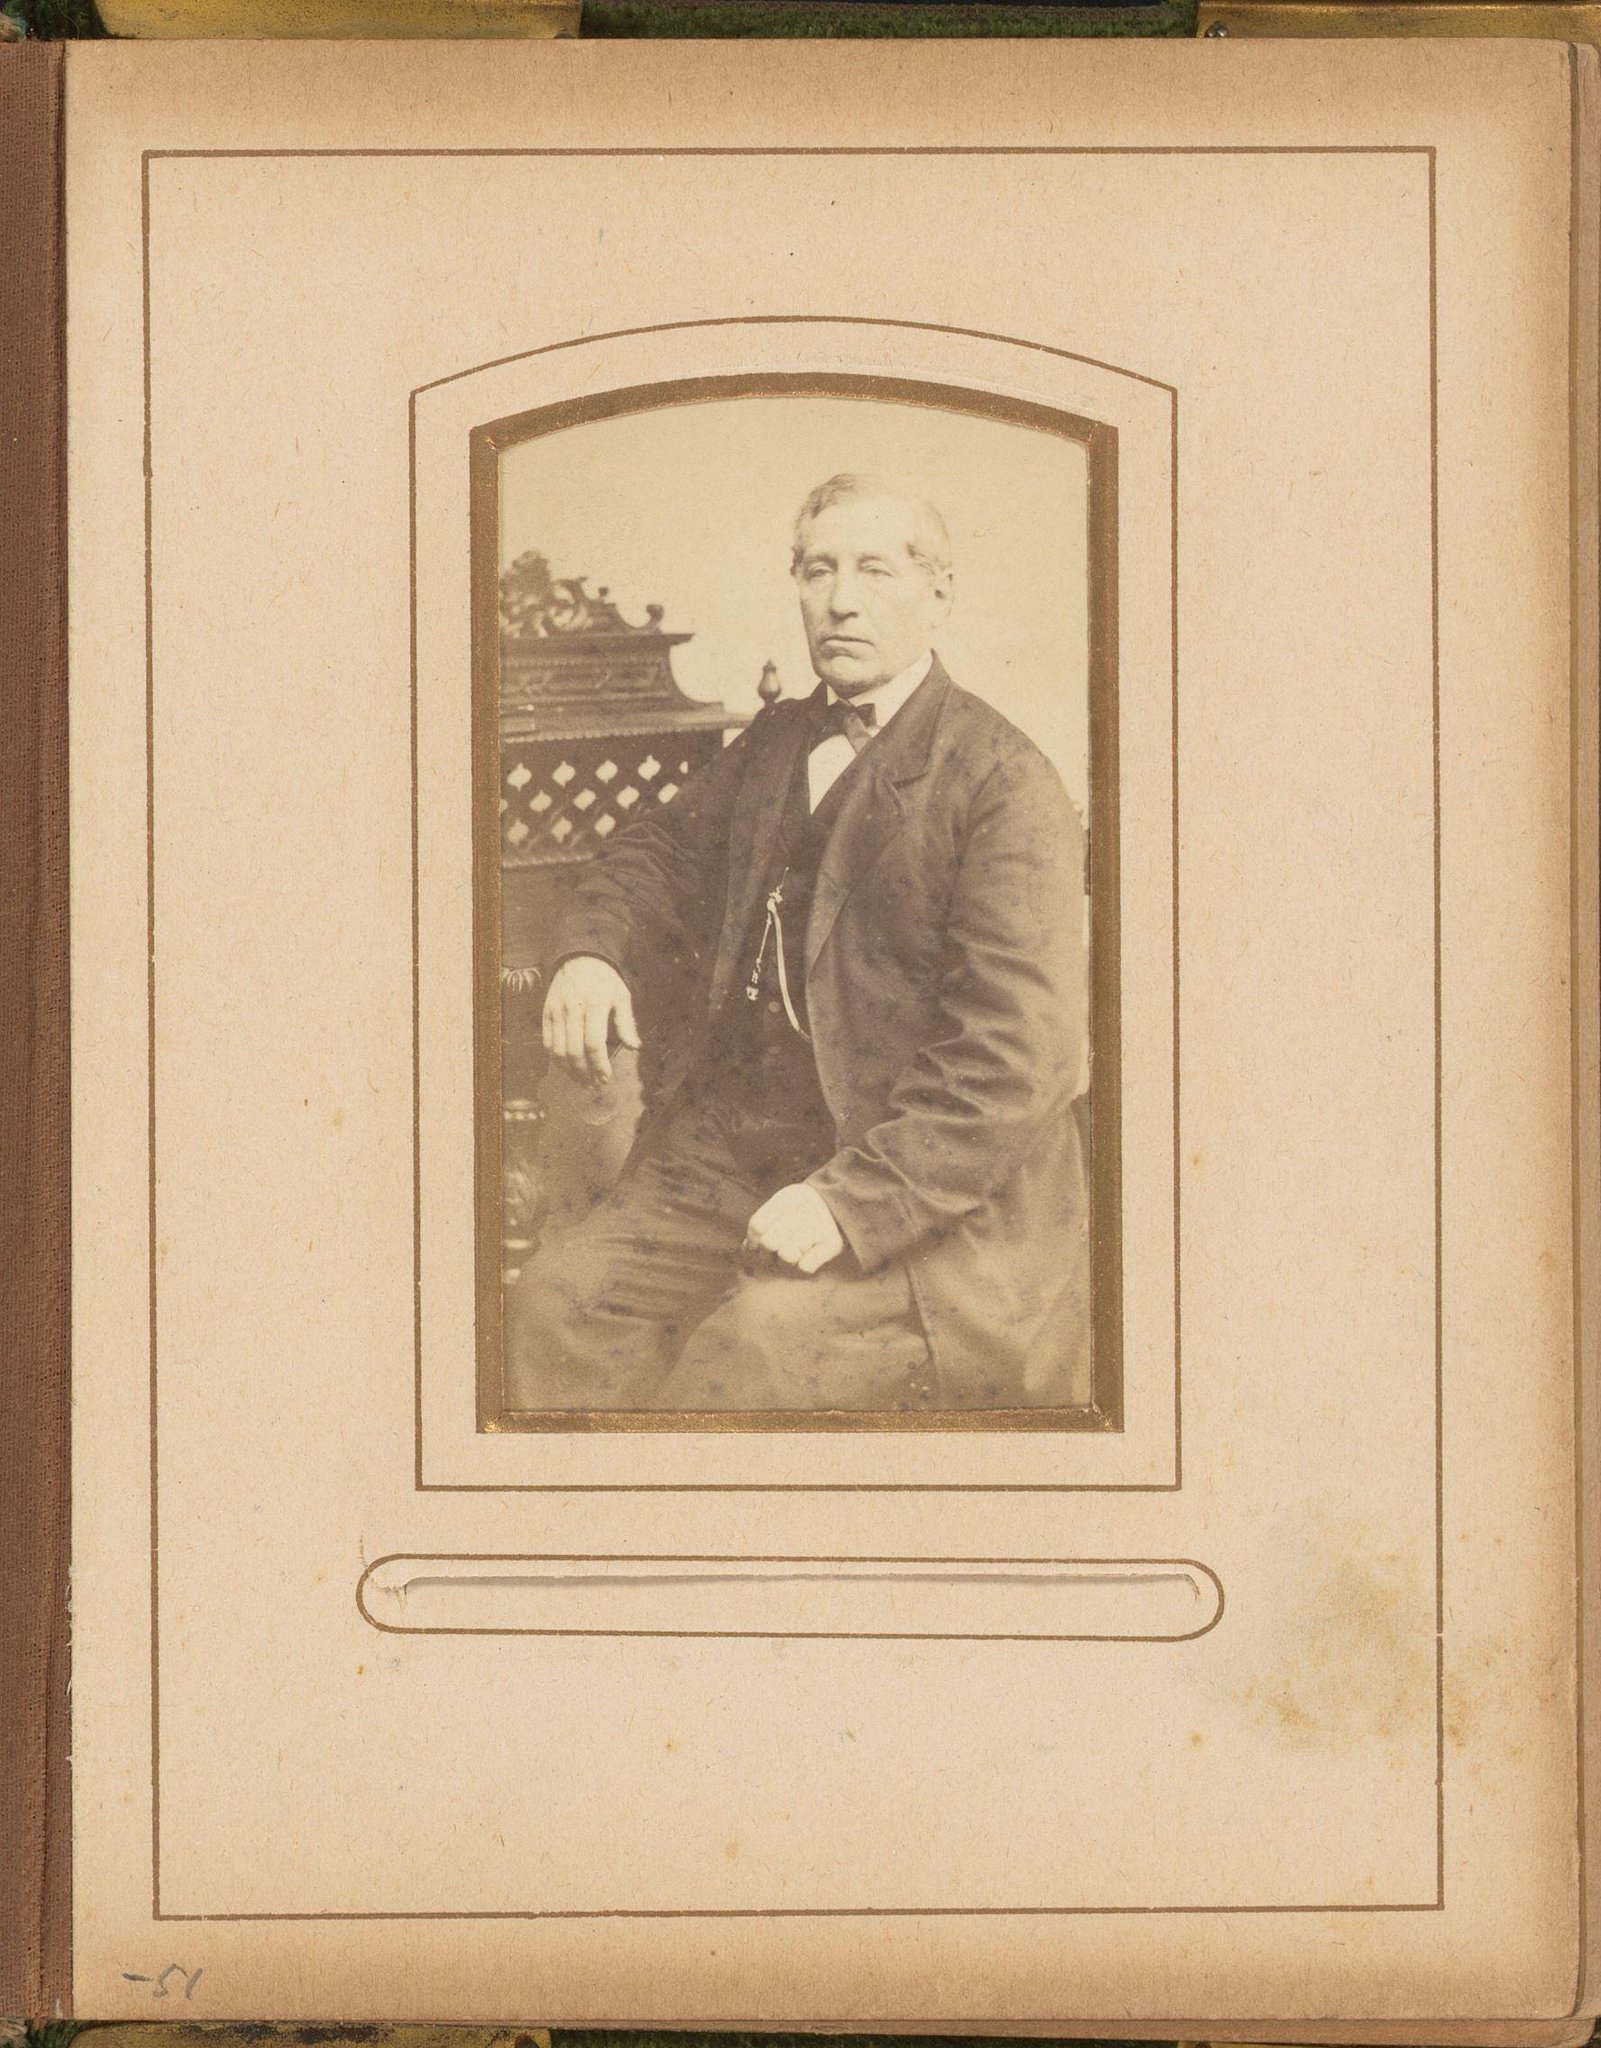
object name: album leaf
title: Portret van een man, mogelijk lid van de familie Beucker Andreae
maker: Anonymous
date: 1854-1914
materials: cardboard, paper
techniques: albumen print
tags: adult man, anonymous historical person portrayed